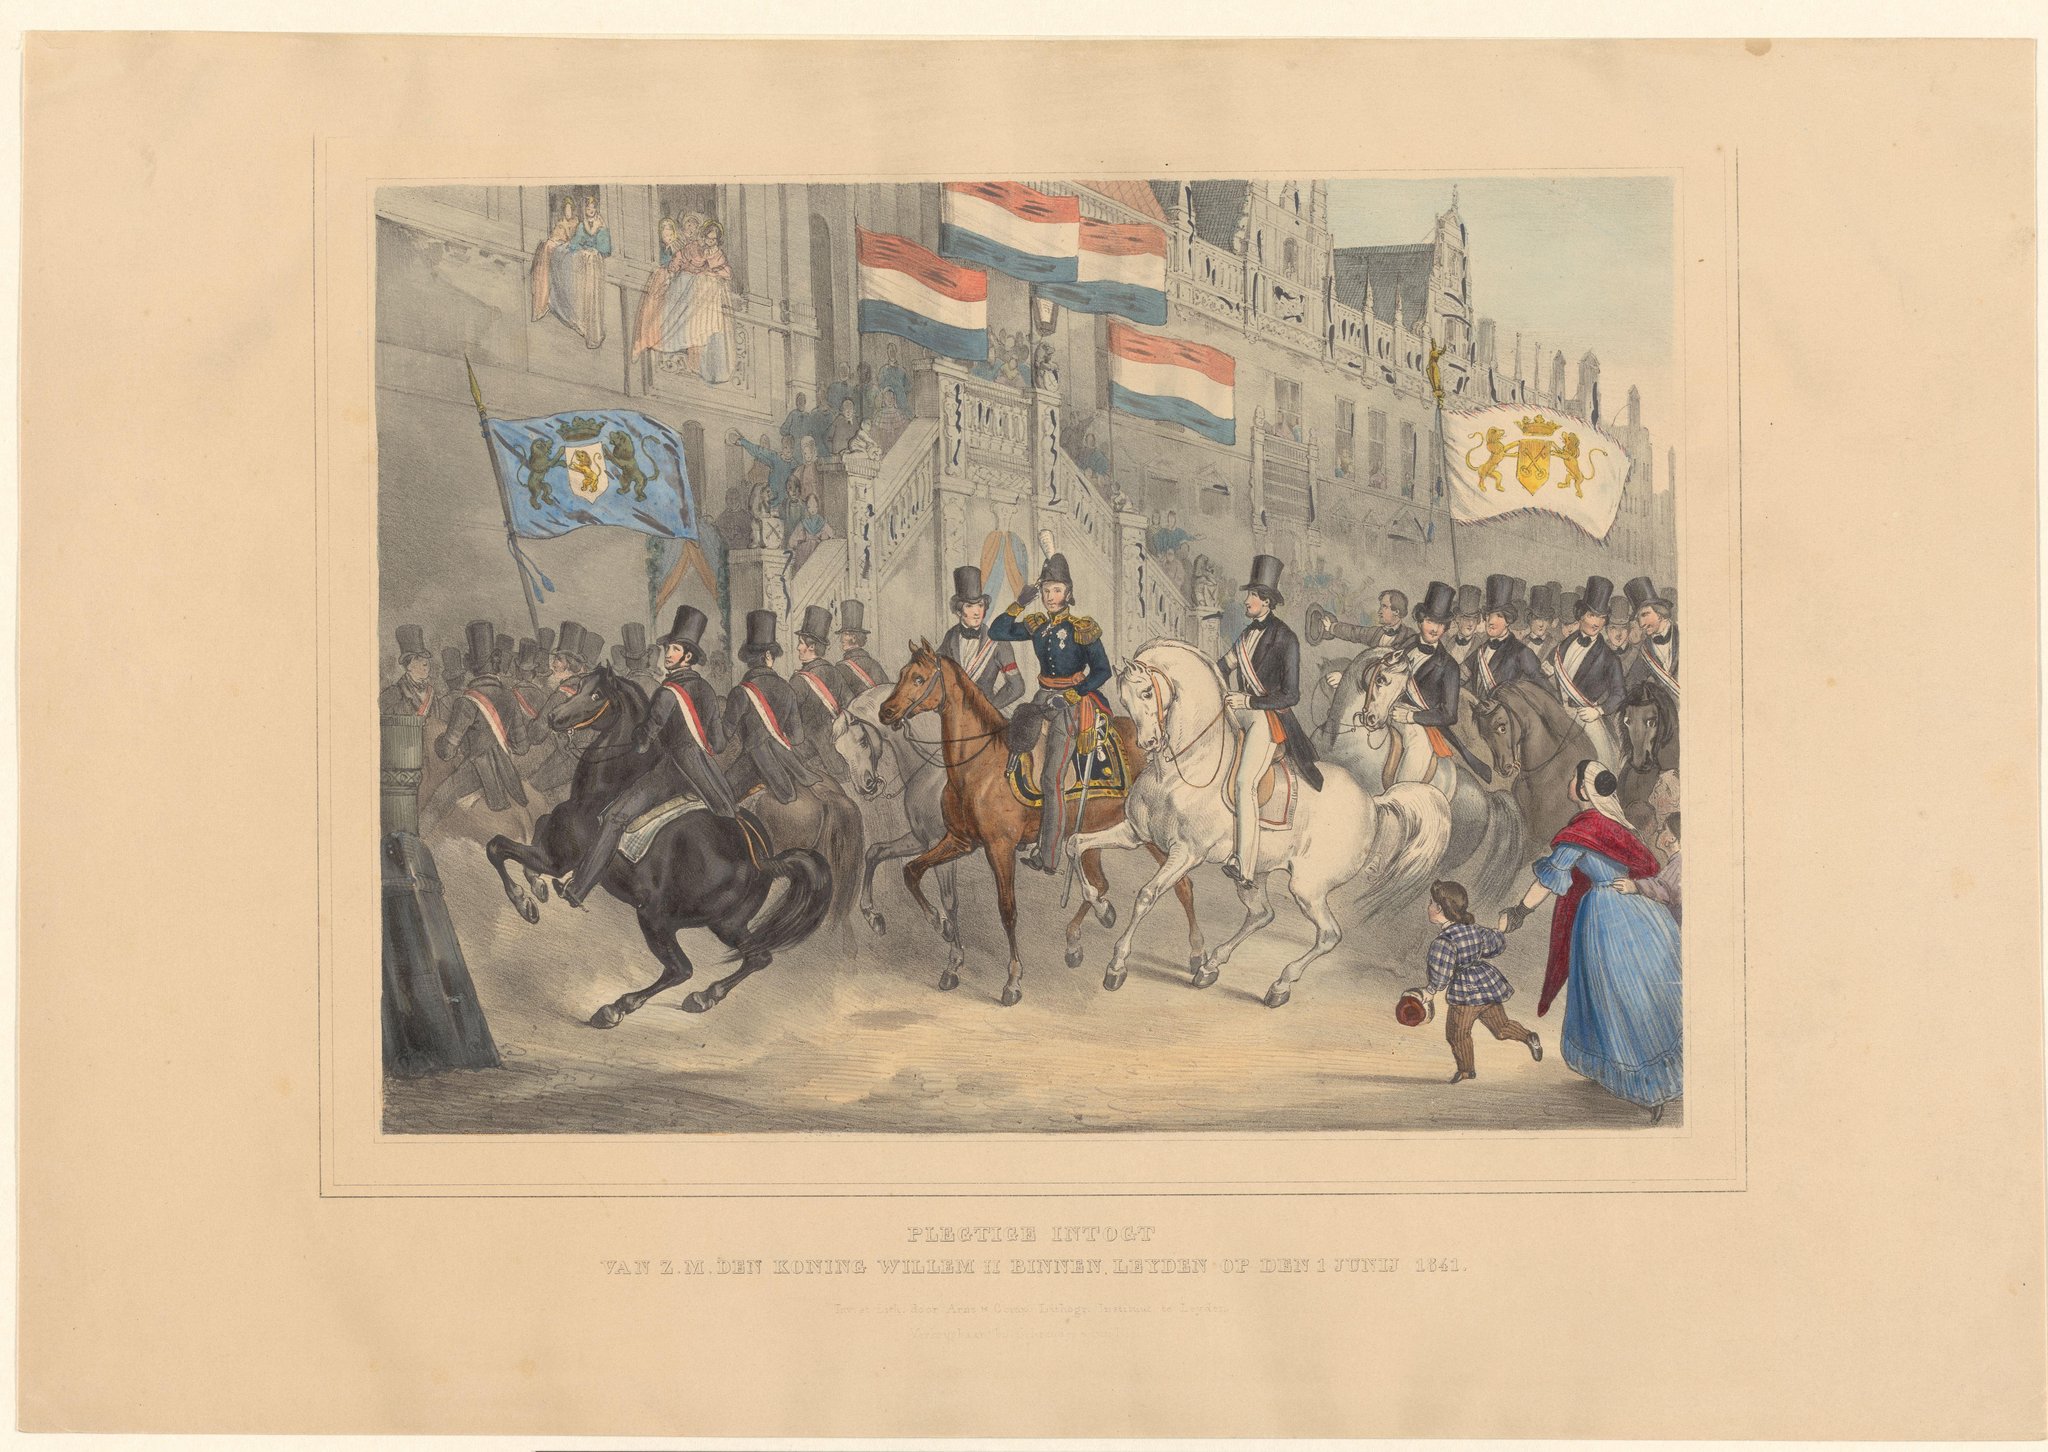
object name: print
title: Plegtige Intogt van Z.M. den Koning Willem II binnen Leyden op den 1 junij 1841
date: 1841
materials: paper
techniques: hand coloring, lithograph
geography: leiden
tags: the hague, william ii of the netherlands, public festivities at other royal events, not meant or mentioned above, triumphal entry and public reception, pageant, 'entrée solennelle', 'joyeuse entrée', leiden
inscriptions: collector's mark: Lugt 2228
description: Intocht van koning Willem II te Leiden, 1 juni 1841. De koning te paard begeleid door een erewacht met twee banieren komt aan bij het stadhuis in de Breestraat te Leiden.